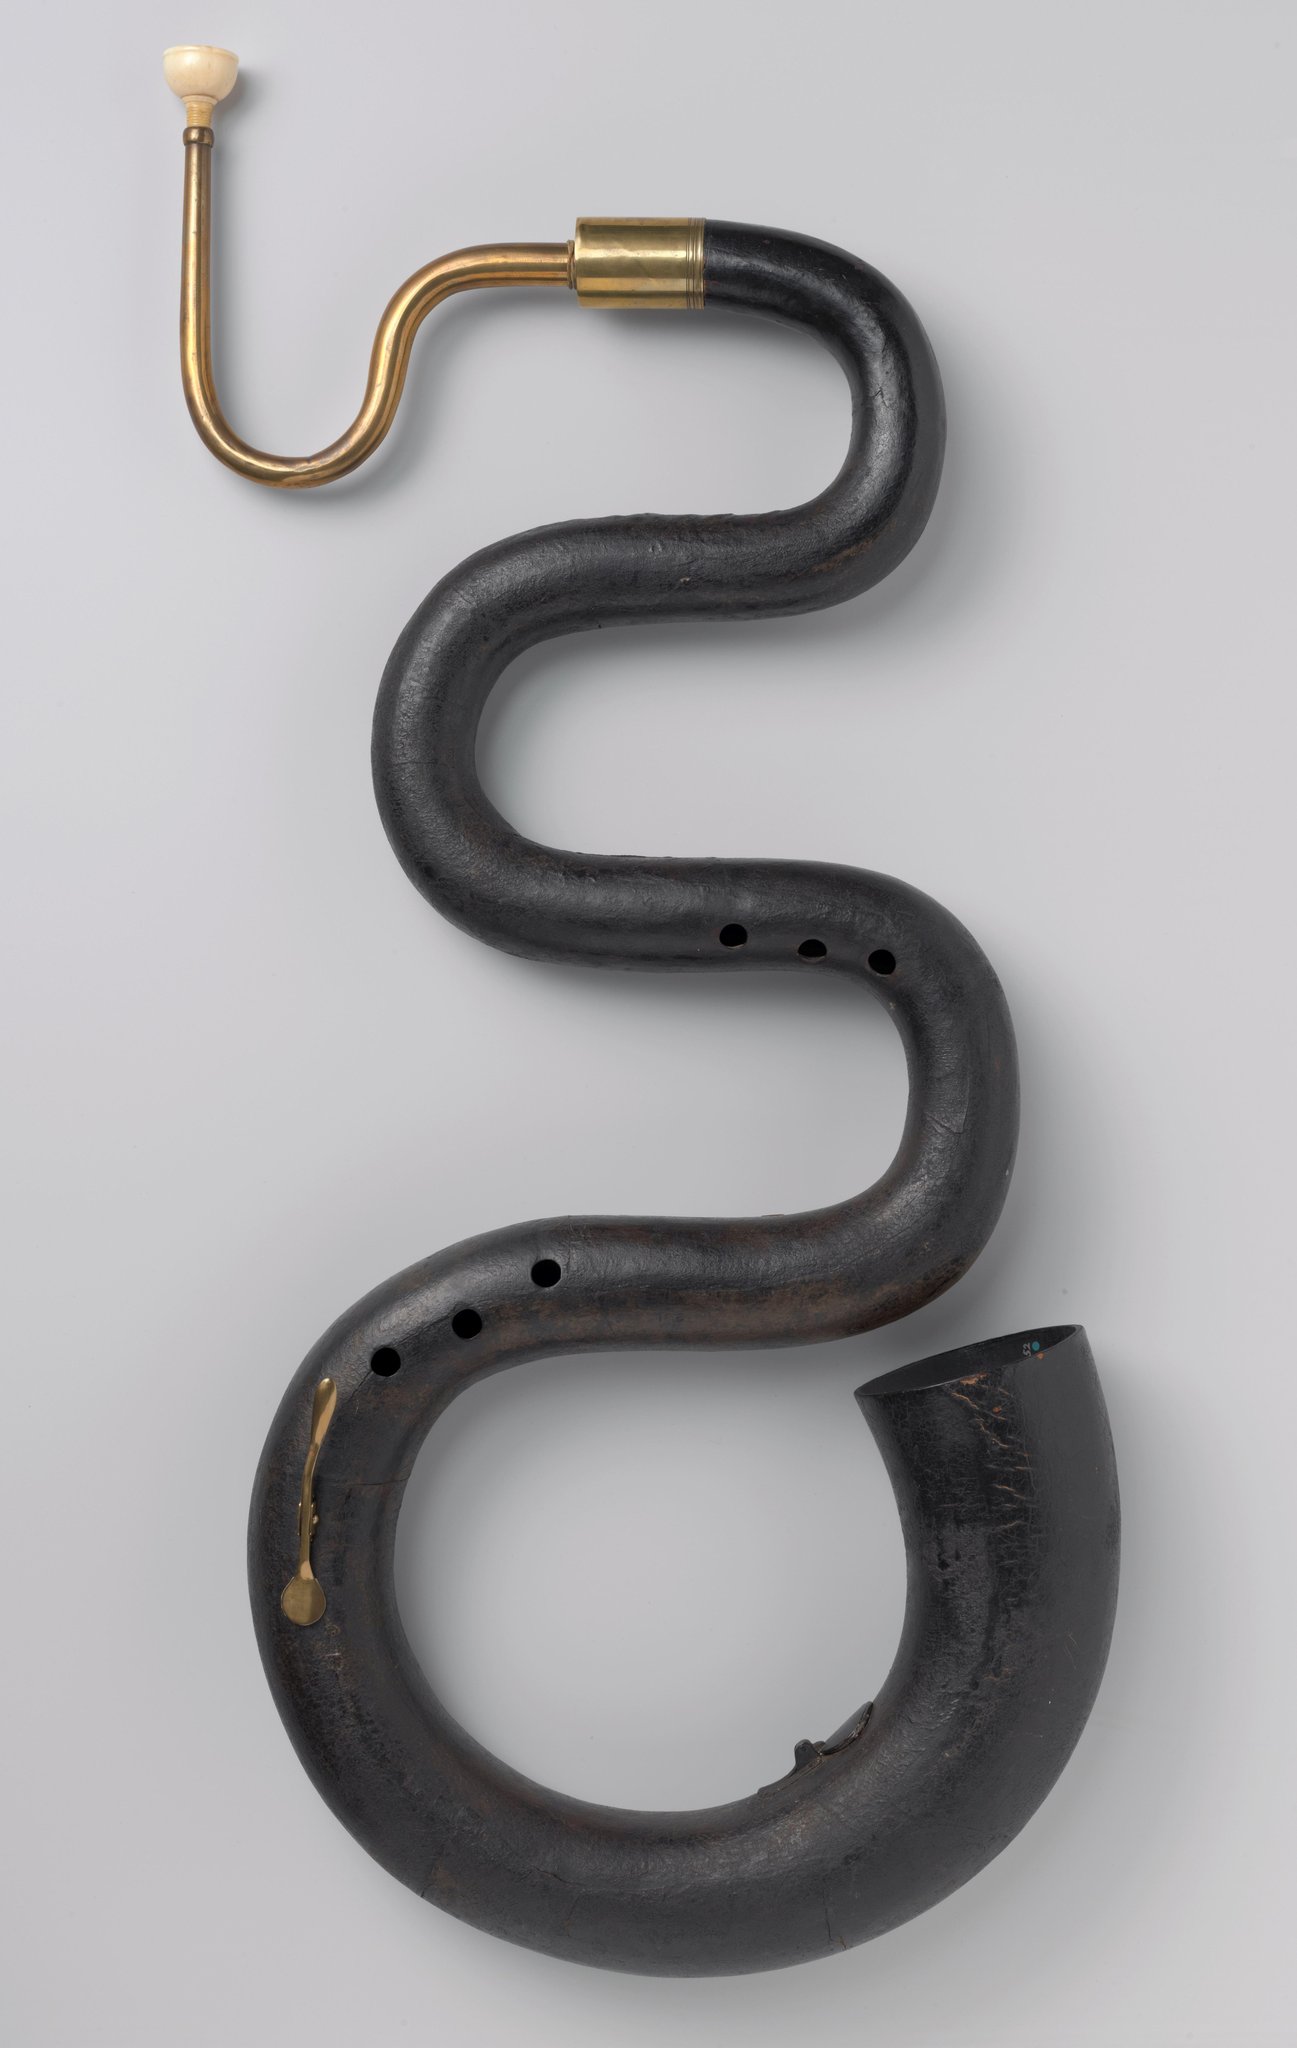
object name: mouthpiece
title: Serpent mouthpiece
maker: Anonymous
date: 1800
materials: ivory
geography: europe